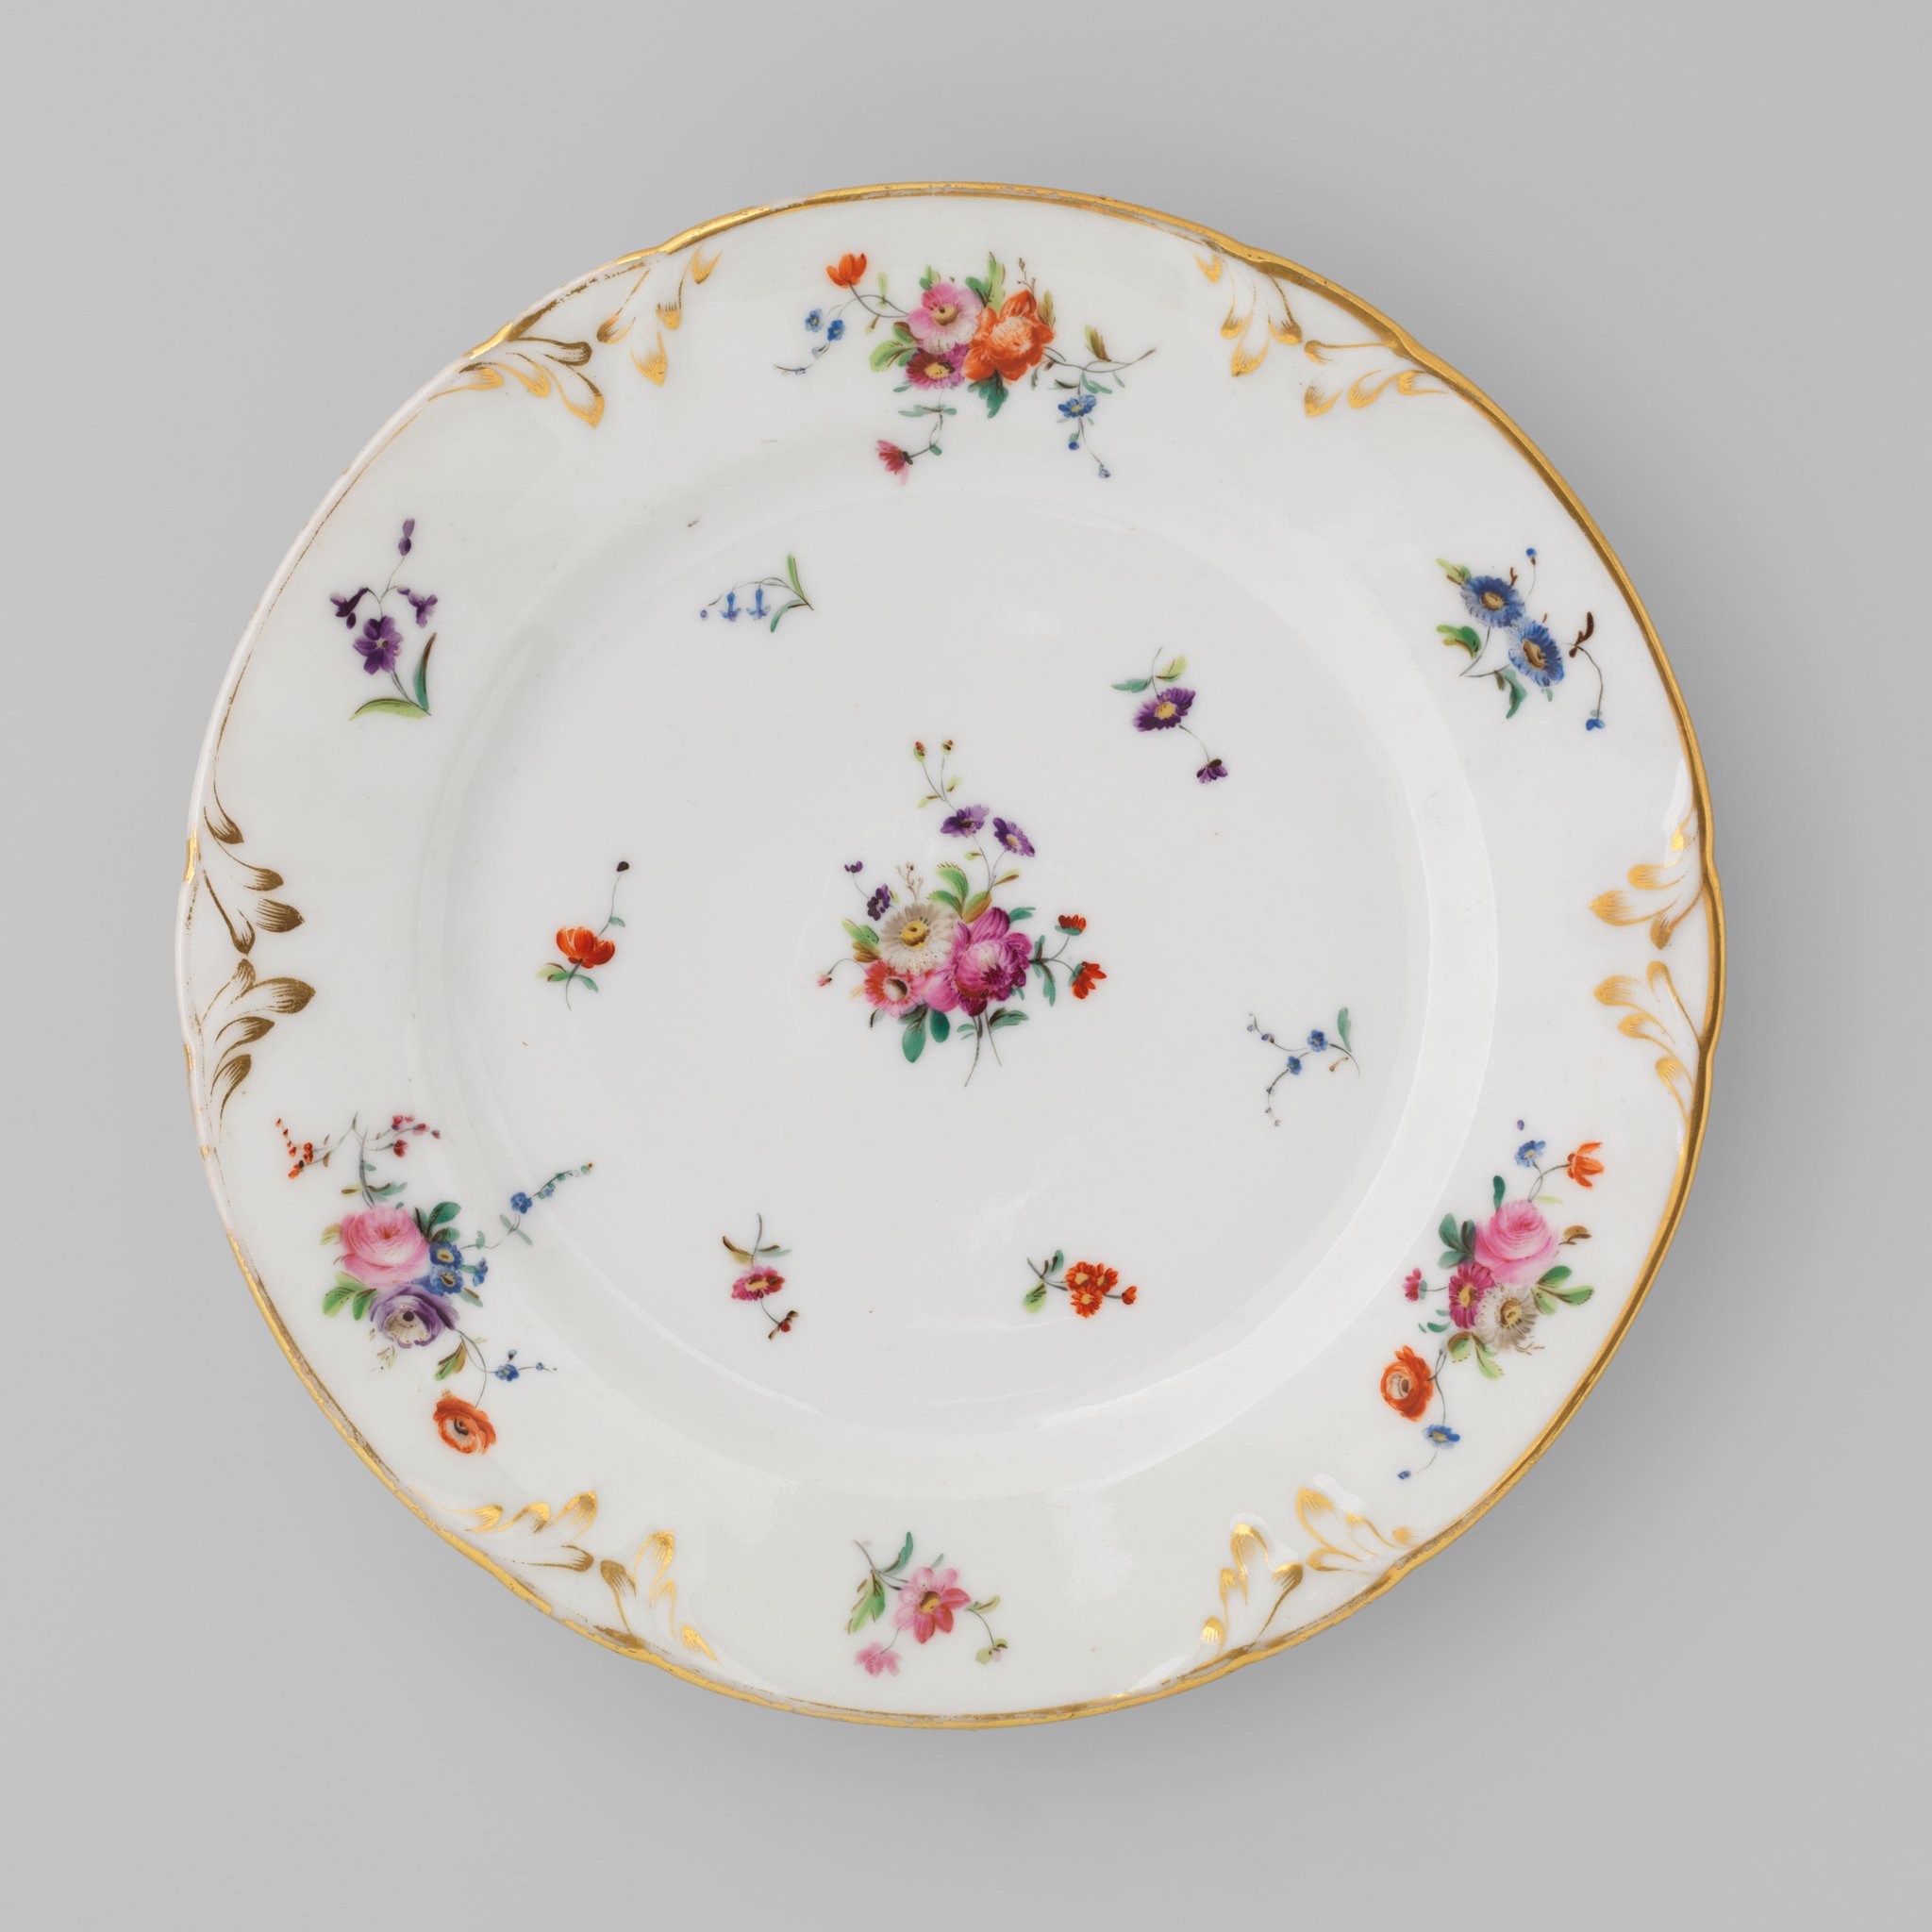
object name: service set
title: Plate with bouquets and flower sprays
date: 1839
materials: glaze, gold, paint, porcelain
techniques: firing, forming, gilding, turning, vitrification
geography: paris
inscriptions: mark: ‘DENUELLE/ Boulevard St. Denis 18/ à Paris’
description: Bord (dessertbord) van porselein met een gelobde rand, beschilderd op het glazuur in blauw, rood, roze, groen, geel, paars, zwart en goud. Op het plat boeketten van verschillende bloemen en strooibloemen. Vanuit de gelobde, gouden rand, gemodelleerde bladranken in reliëf, aangezet met goud. Hiertussen boeketten. Drie proenen op de onderzijde. Gemerkt op de onderzijde met 'DENUELLE/ Boulevard St. Denis 18/ à Paris'.